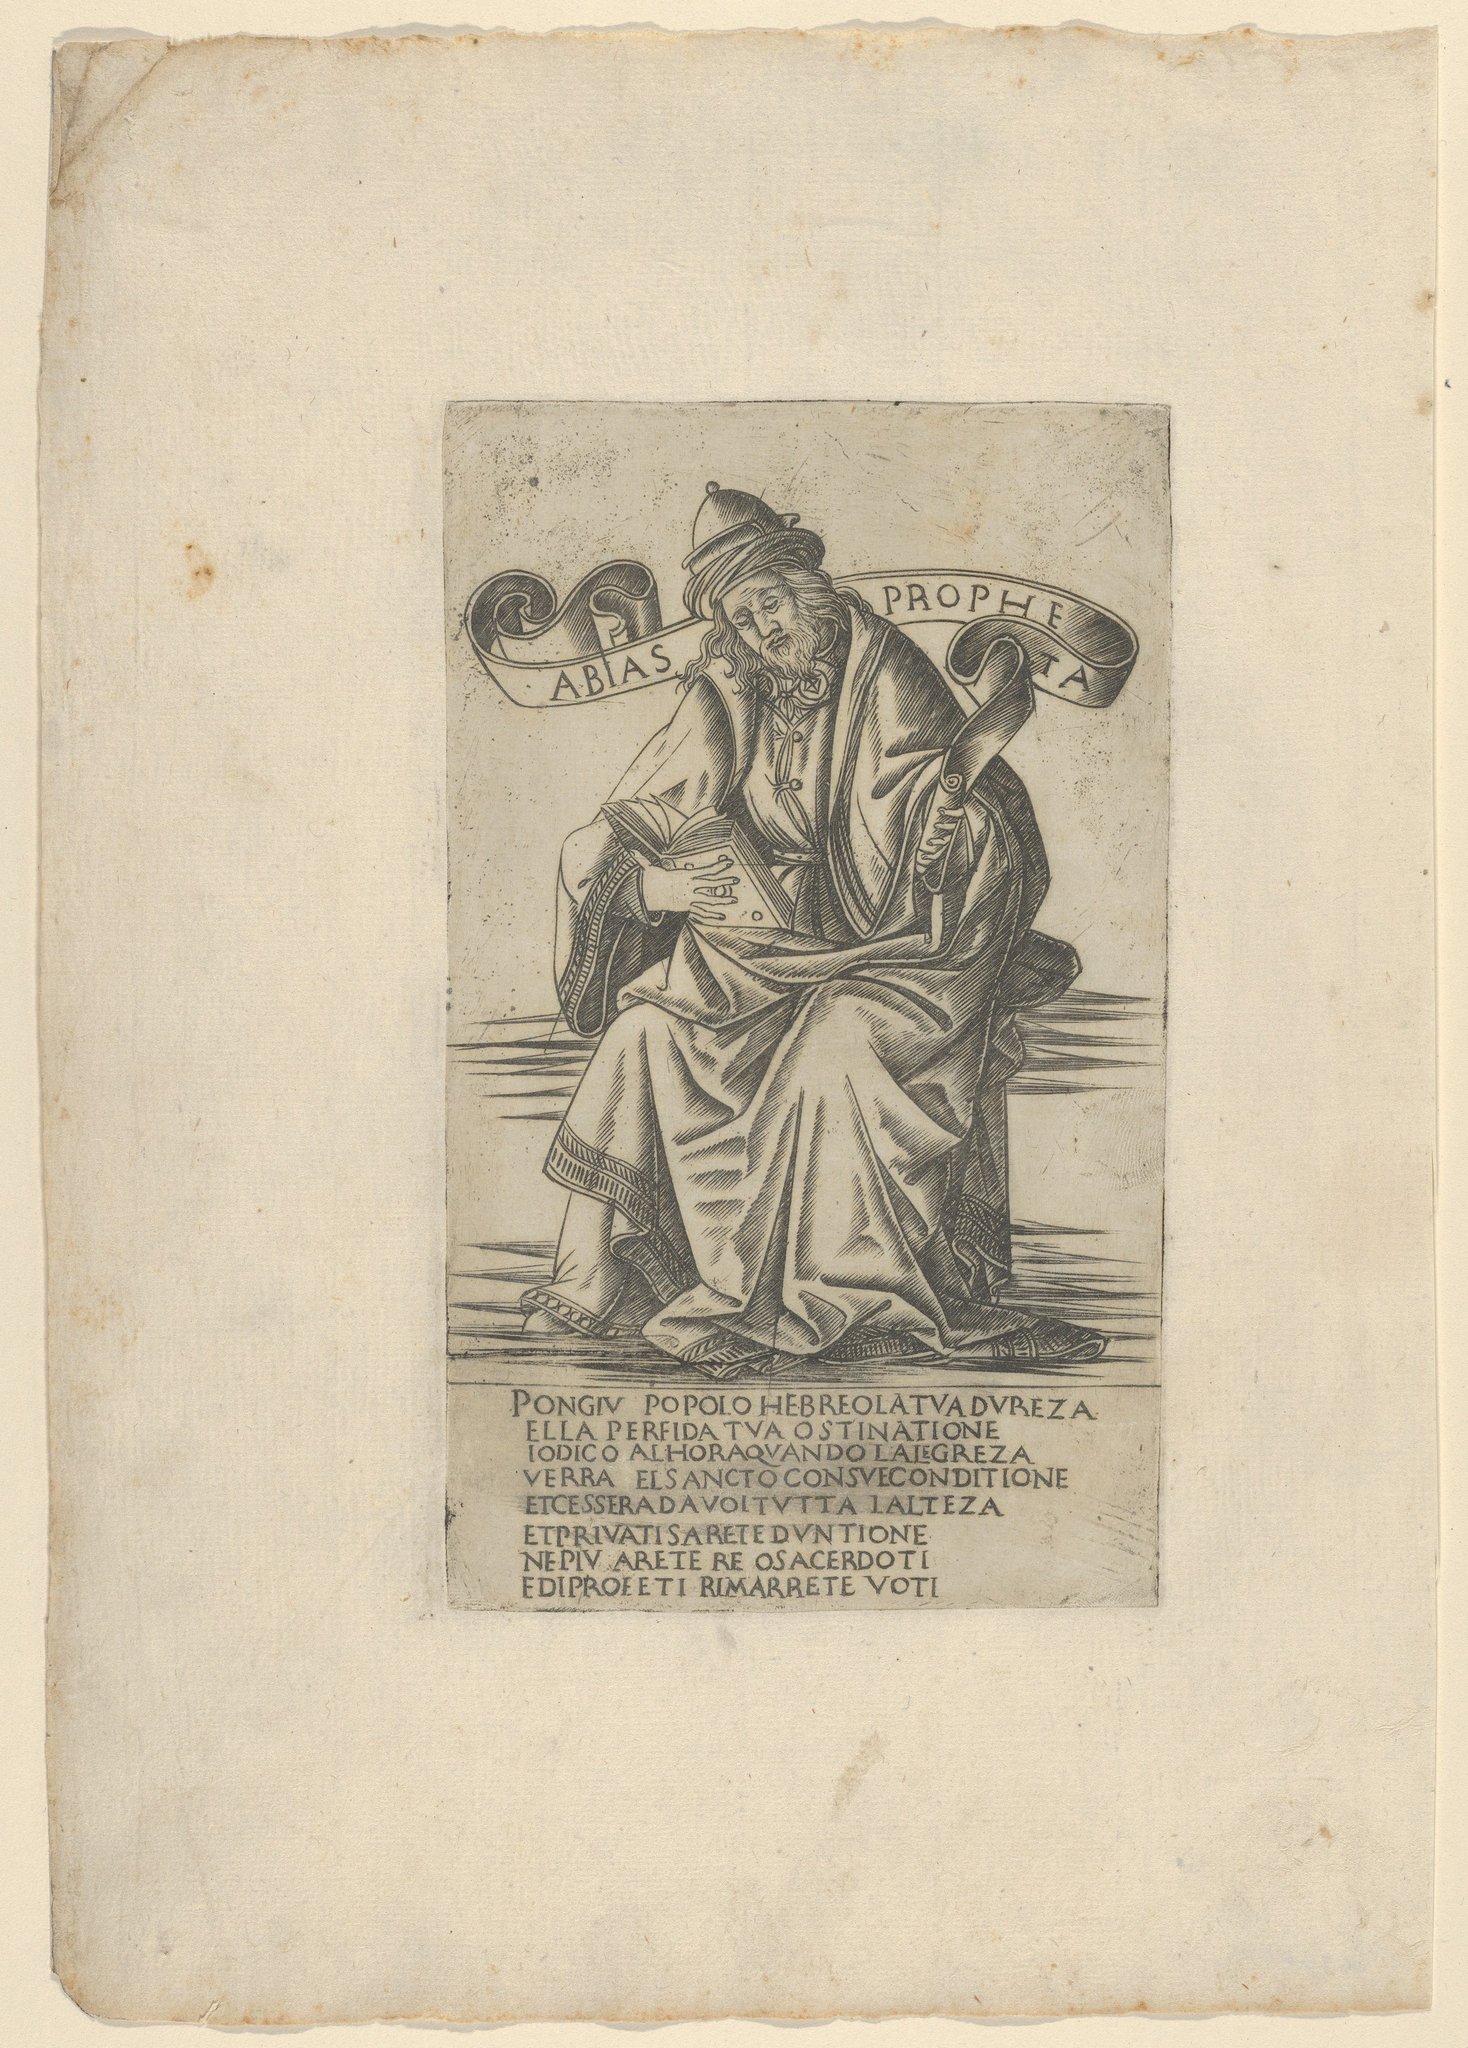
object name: print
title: The Prophet Obadiah, from Prophets and Sibyls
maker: francesco rosselli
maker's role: artist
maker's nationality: italian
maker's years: 1448-1527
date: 1480-1490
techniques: engraving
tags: men,reading